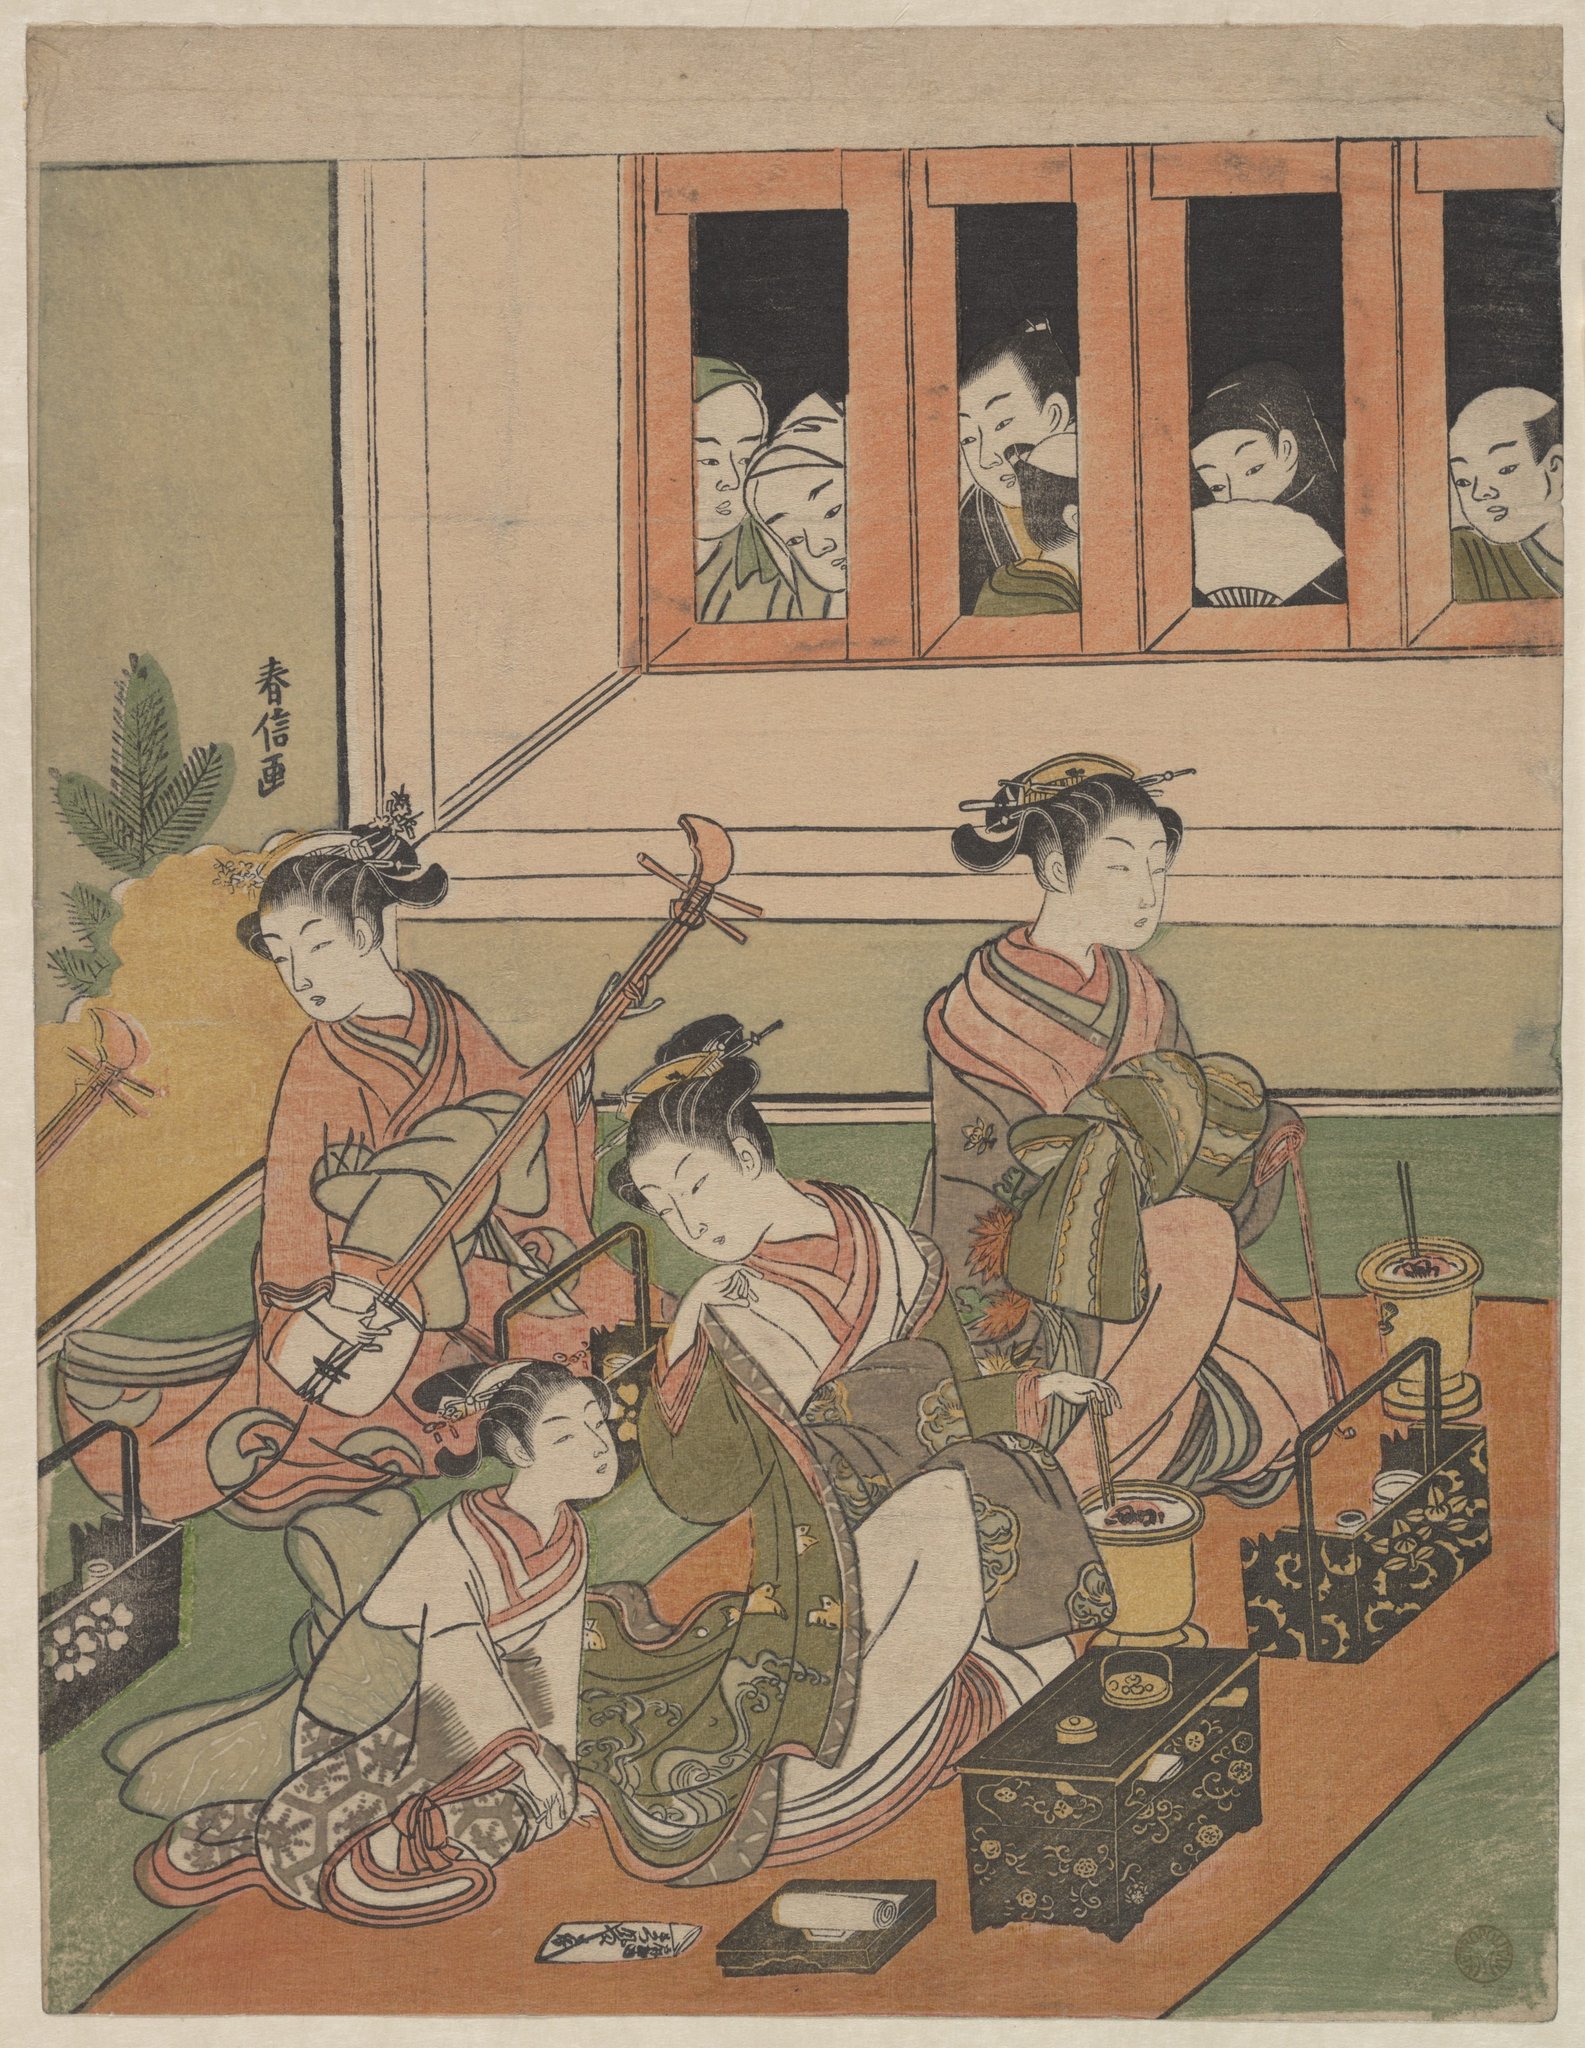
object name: print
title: The Watchers and the Watched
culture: japanese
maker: suzuki harunobu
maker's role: artist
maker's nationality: japanese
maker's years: 1725-1770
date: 1764-1772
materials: ink, paper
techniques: woodblock print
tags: musical instruments,men,women